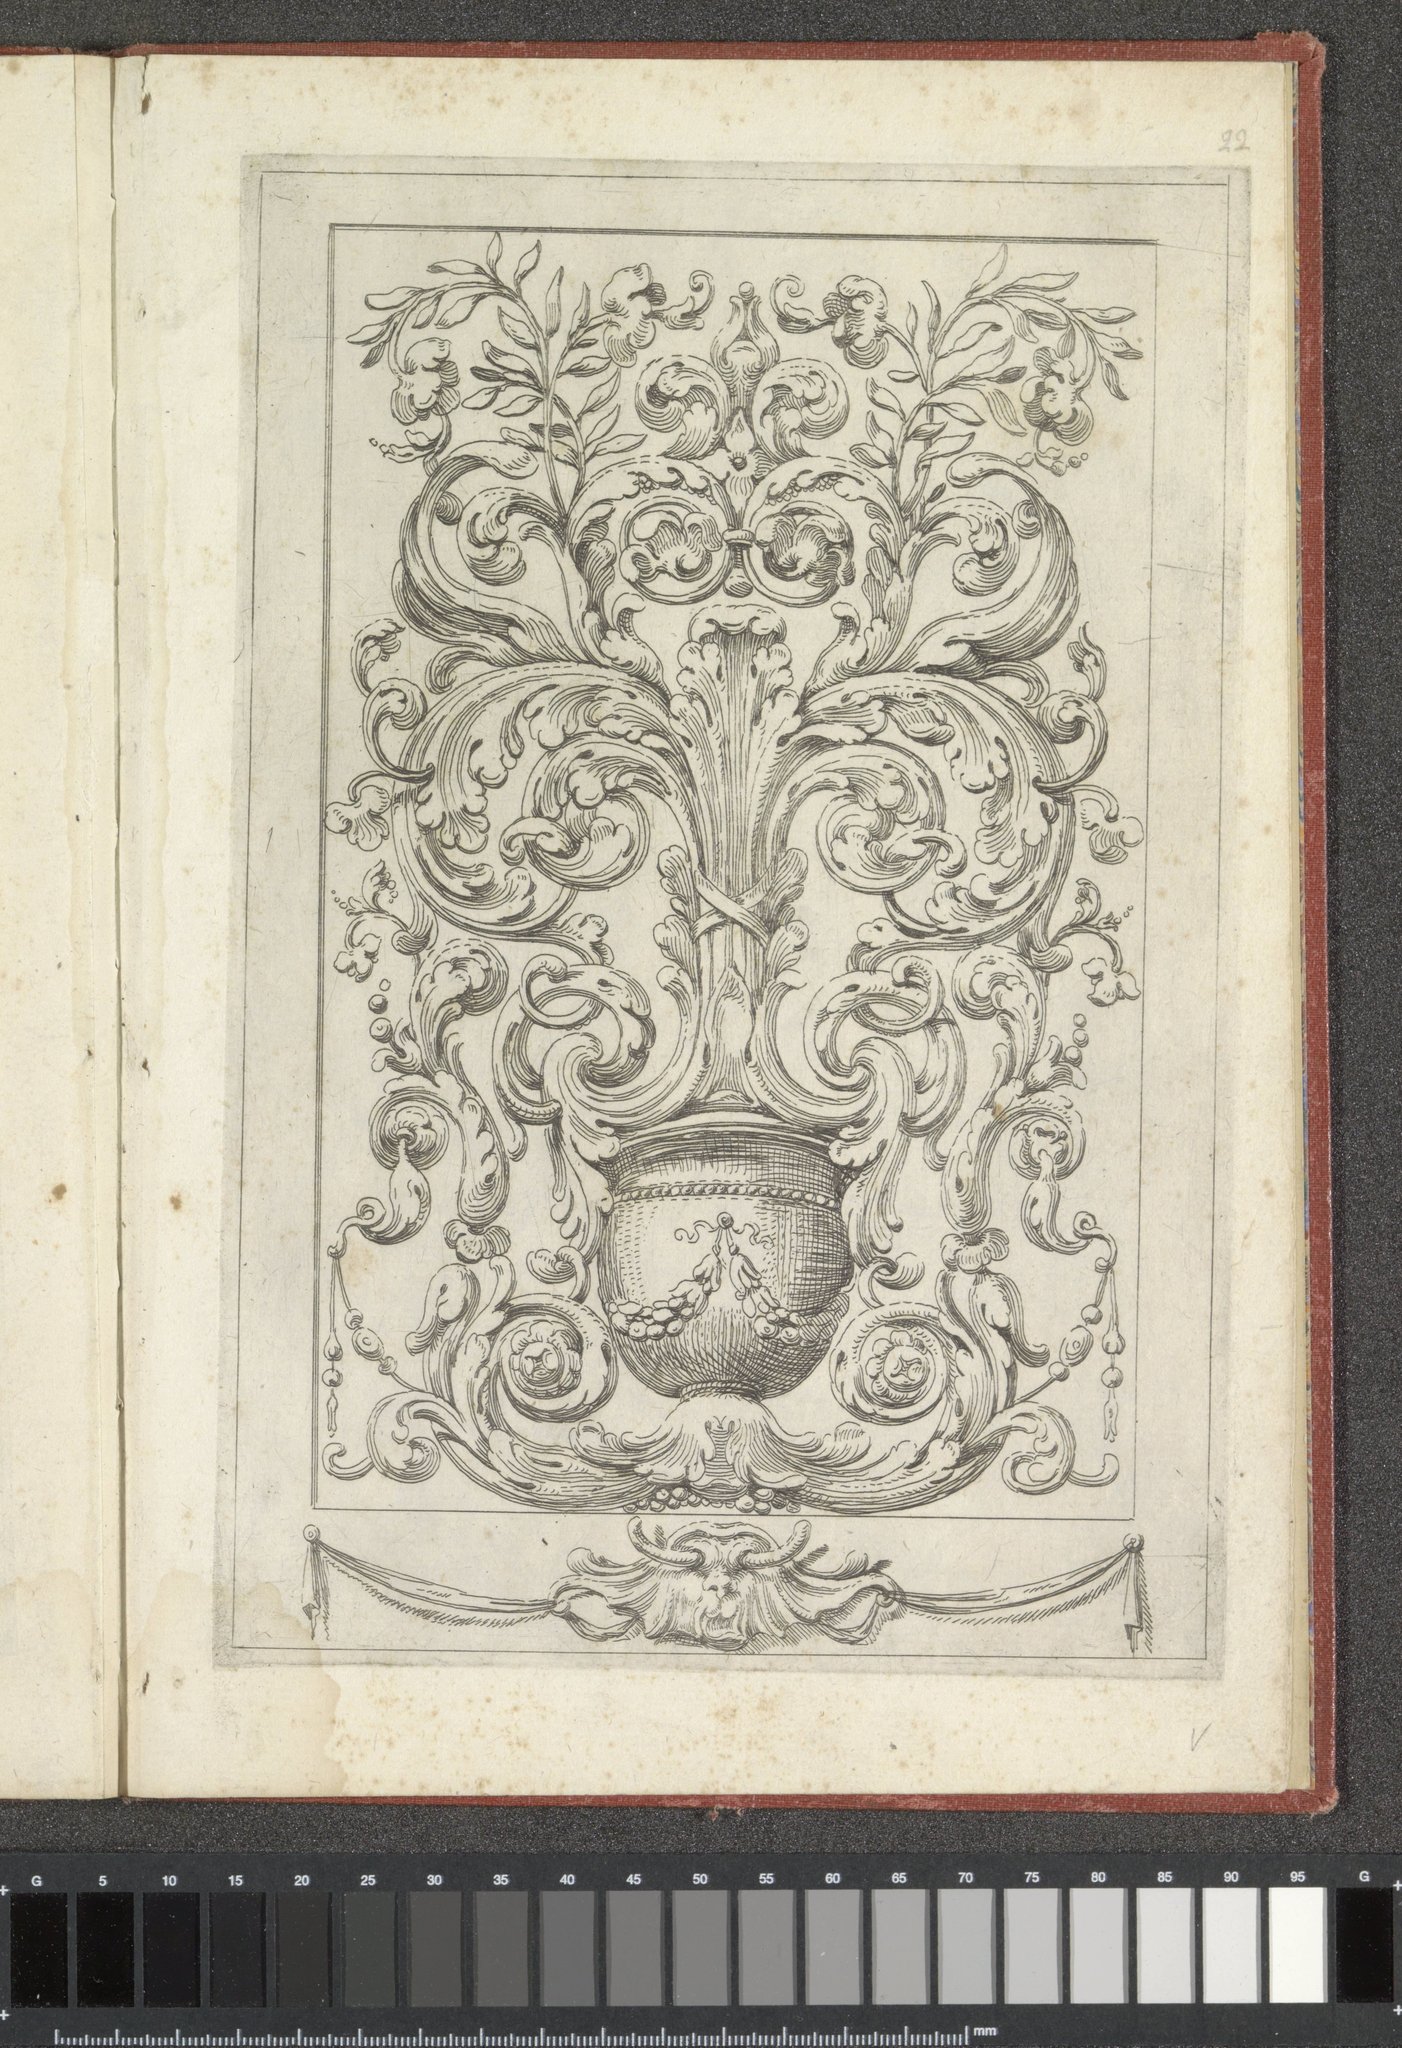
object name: print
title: Cartouches par Mitelli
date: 1636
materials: paper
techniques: etching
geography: rome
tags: rocaille ornament, vase ~ ornament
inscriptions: collector's mark: Lugt 2760, collector's mark: Lugt 2228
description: Een ornament van een vaas waaromheen rocailles krullen. Onder een ornamentkop die hangt aan linten. De prent maakt deel uit van een album.